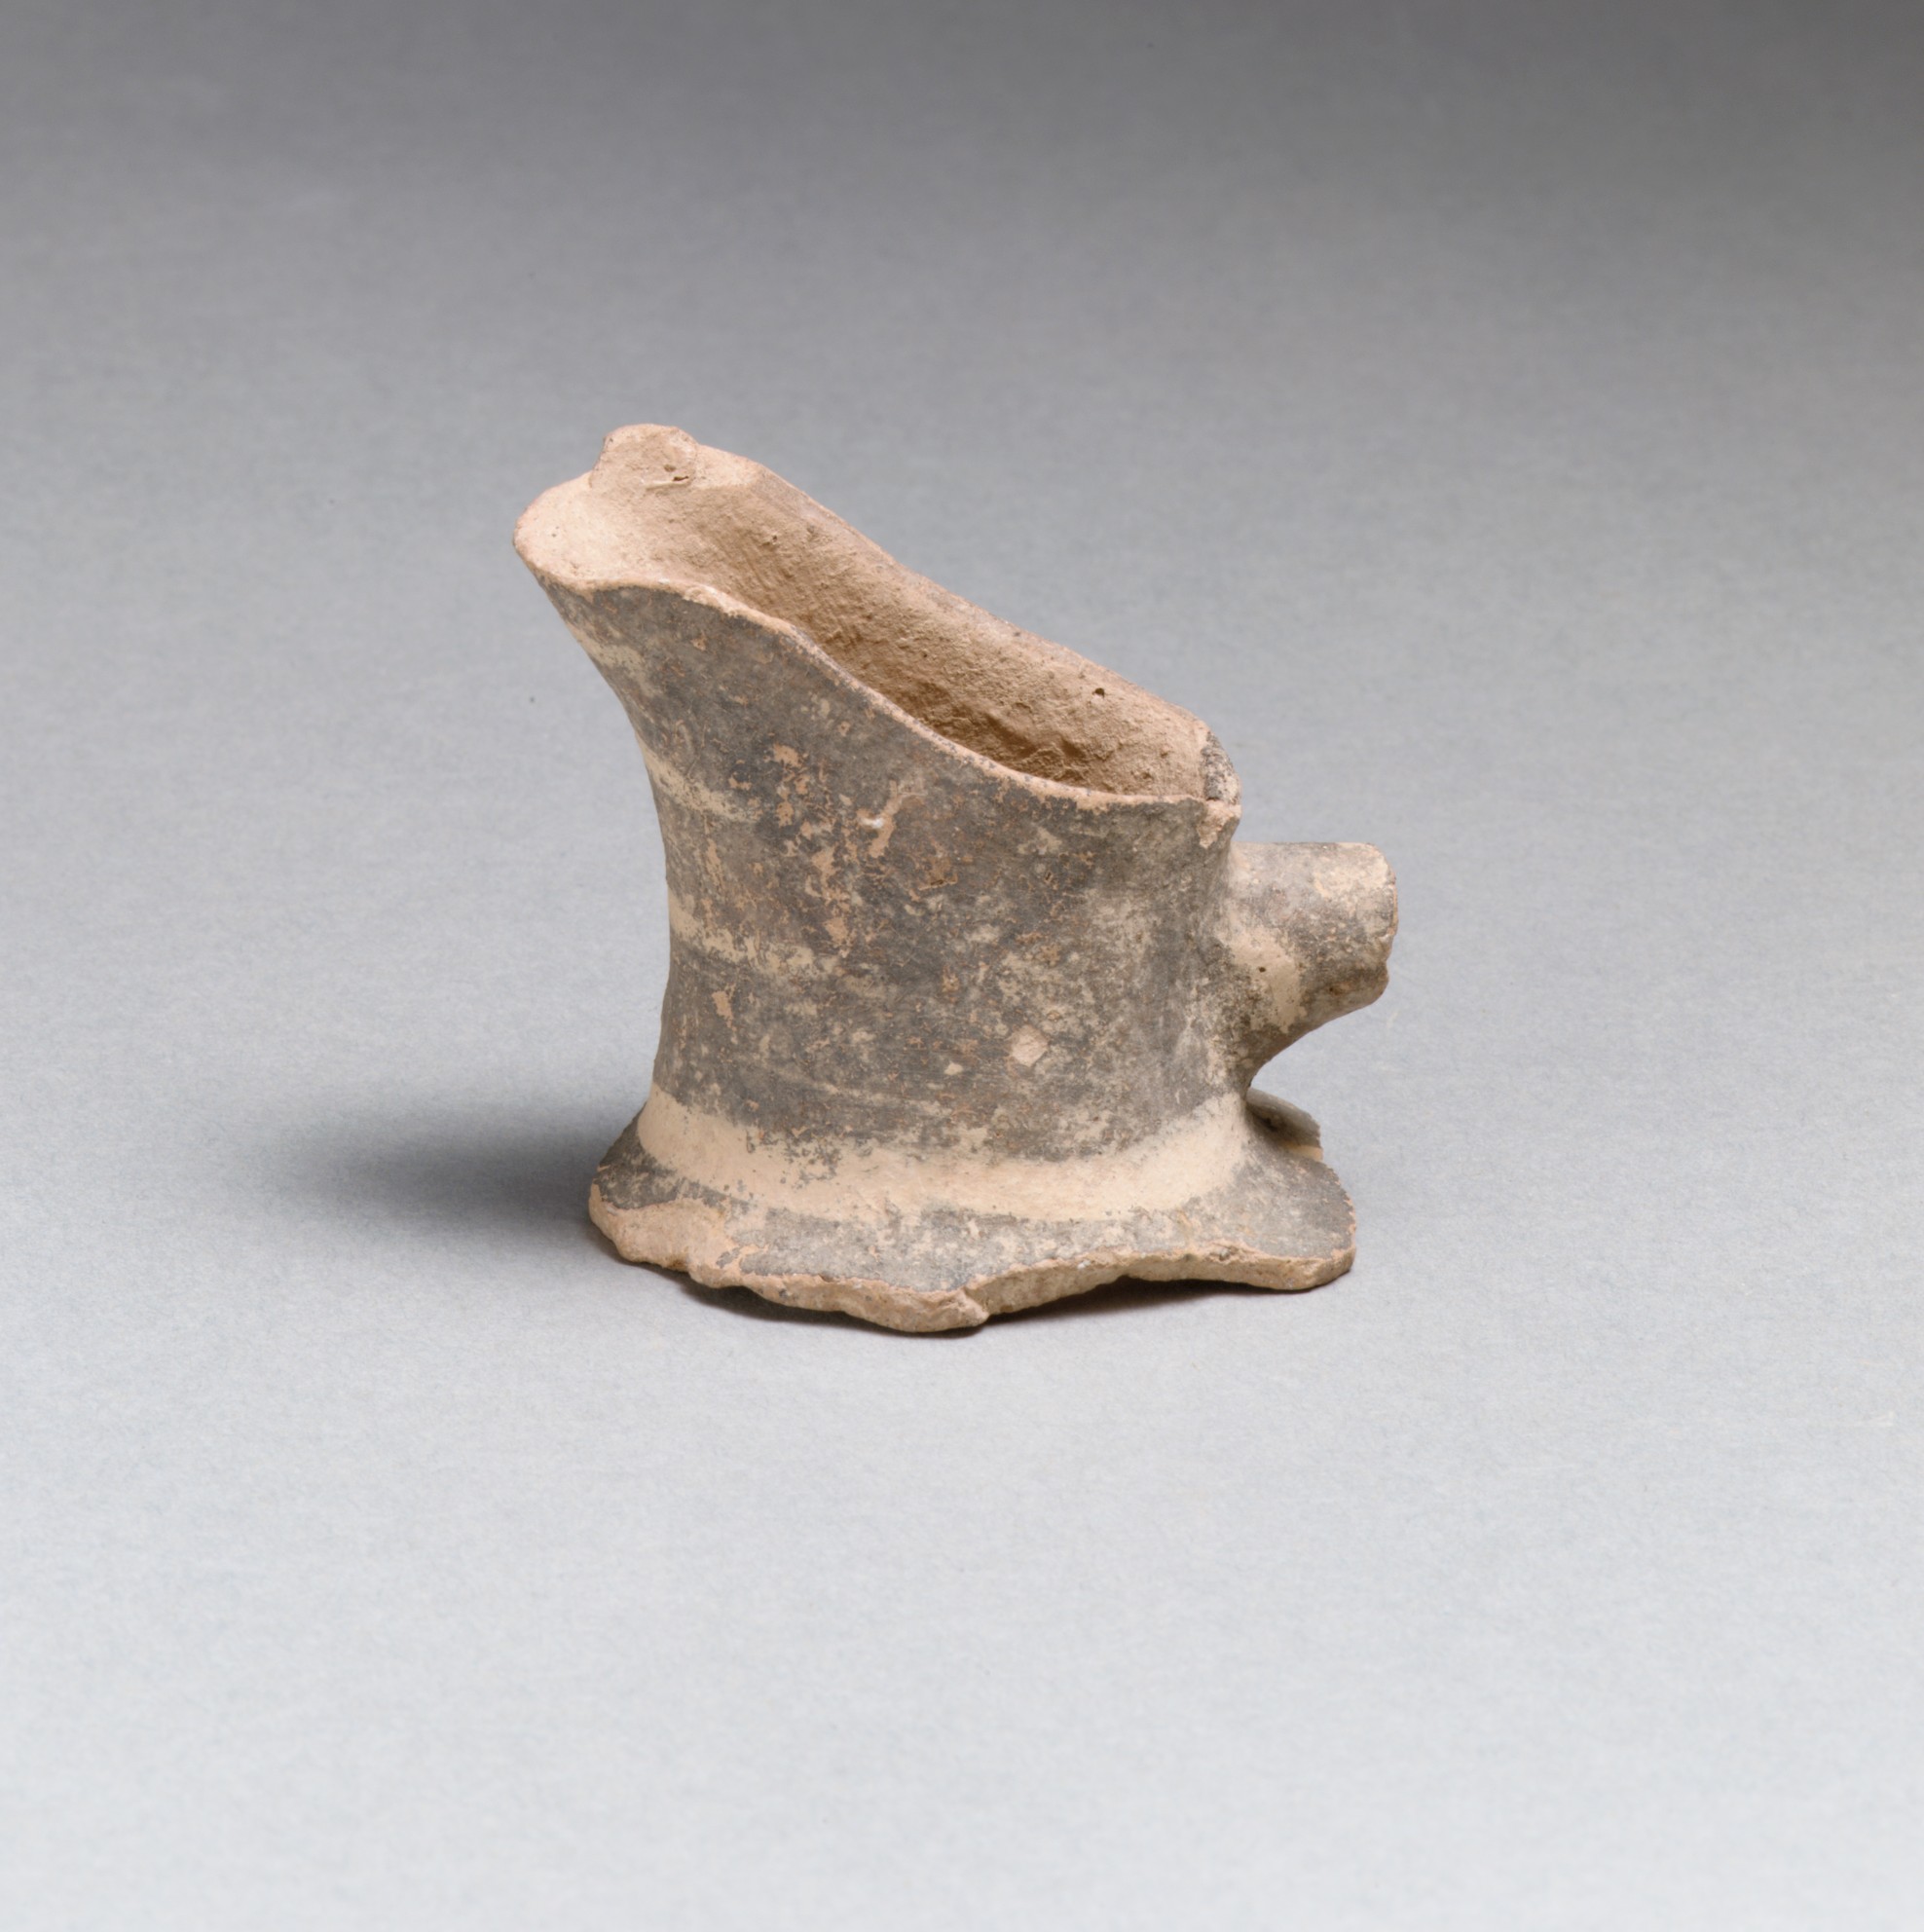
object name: vase fragment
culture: minoan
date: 2600-2000 BCE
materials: terracotta